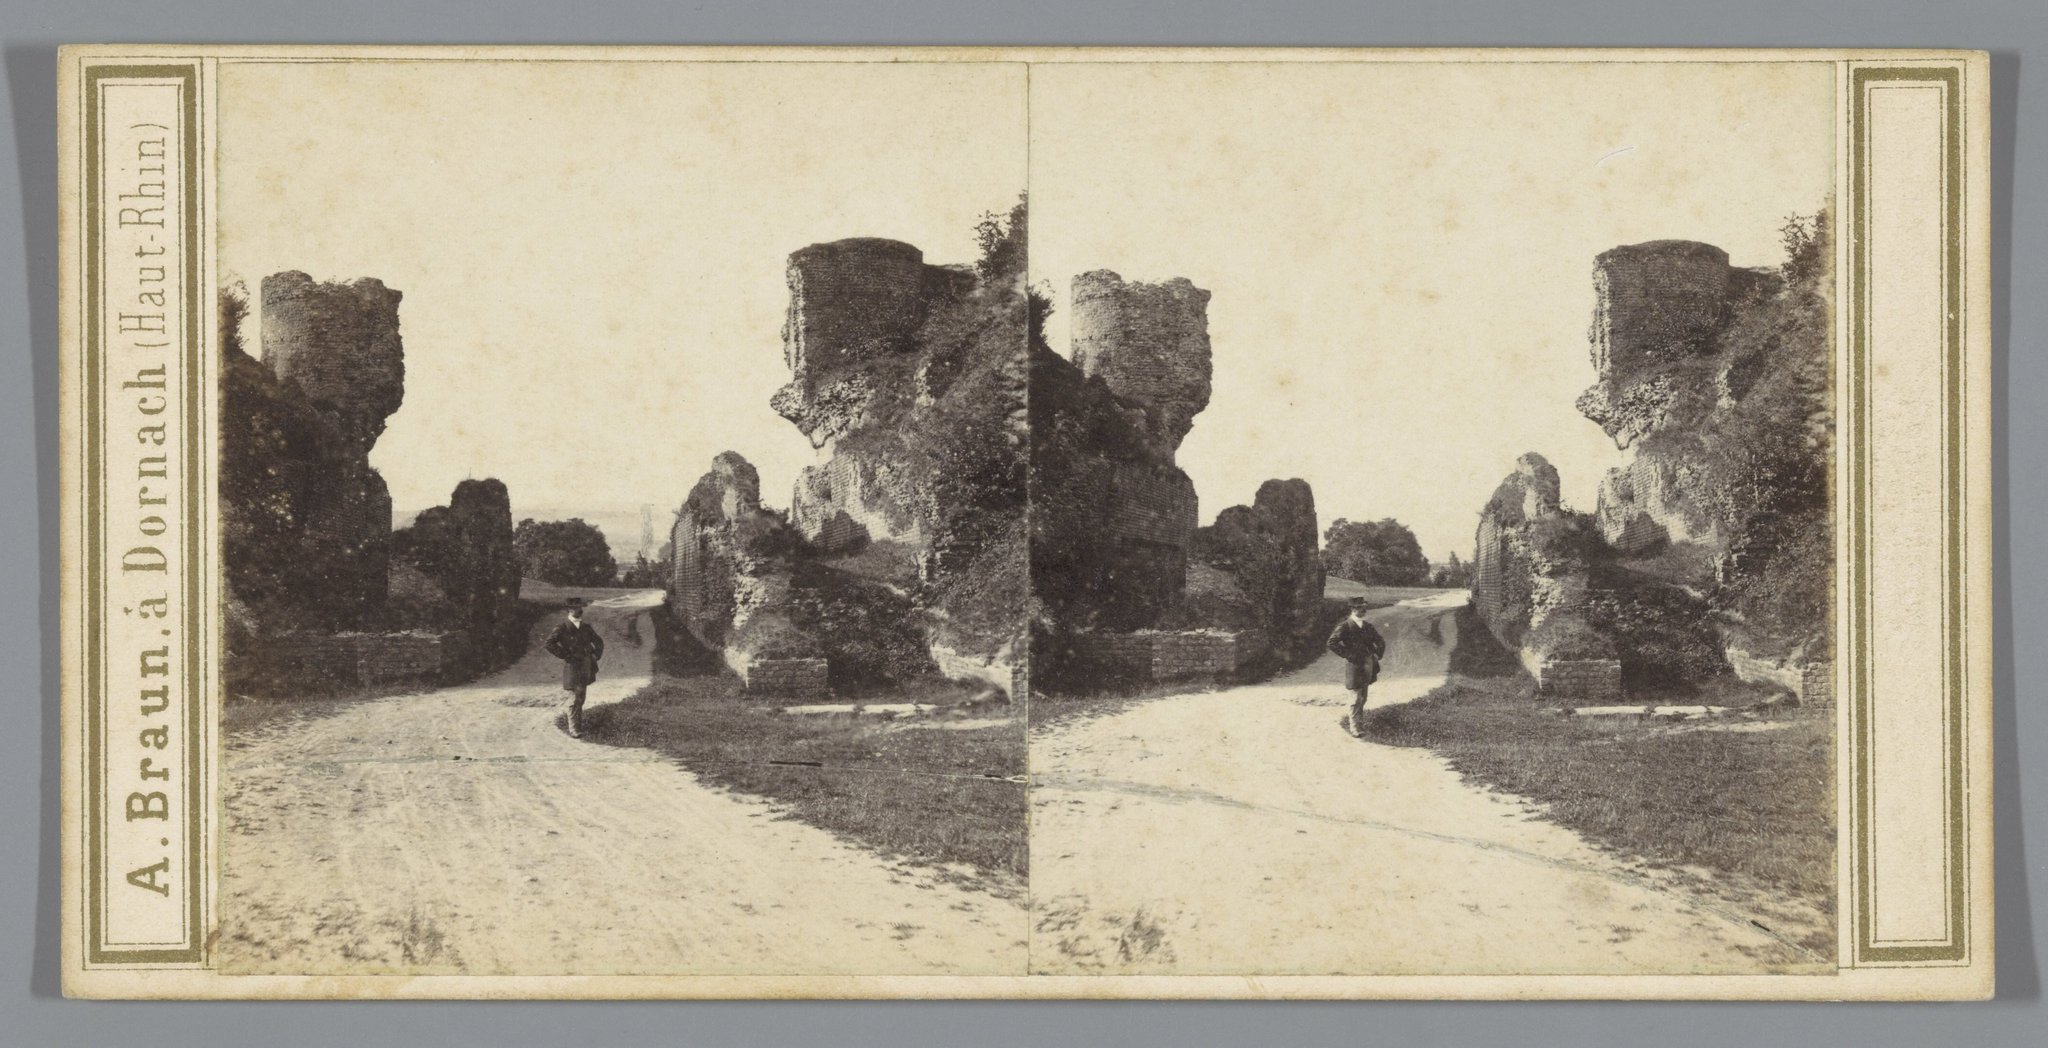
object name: stereograph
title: Trêves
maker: Anonymous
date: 1860-1866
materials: cardboard, paper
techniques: albumen print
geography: dornach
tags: amphitheatre, landscape with ruins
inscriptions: number: ‘No 2705.’